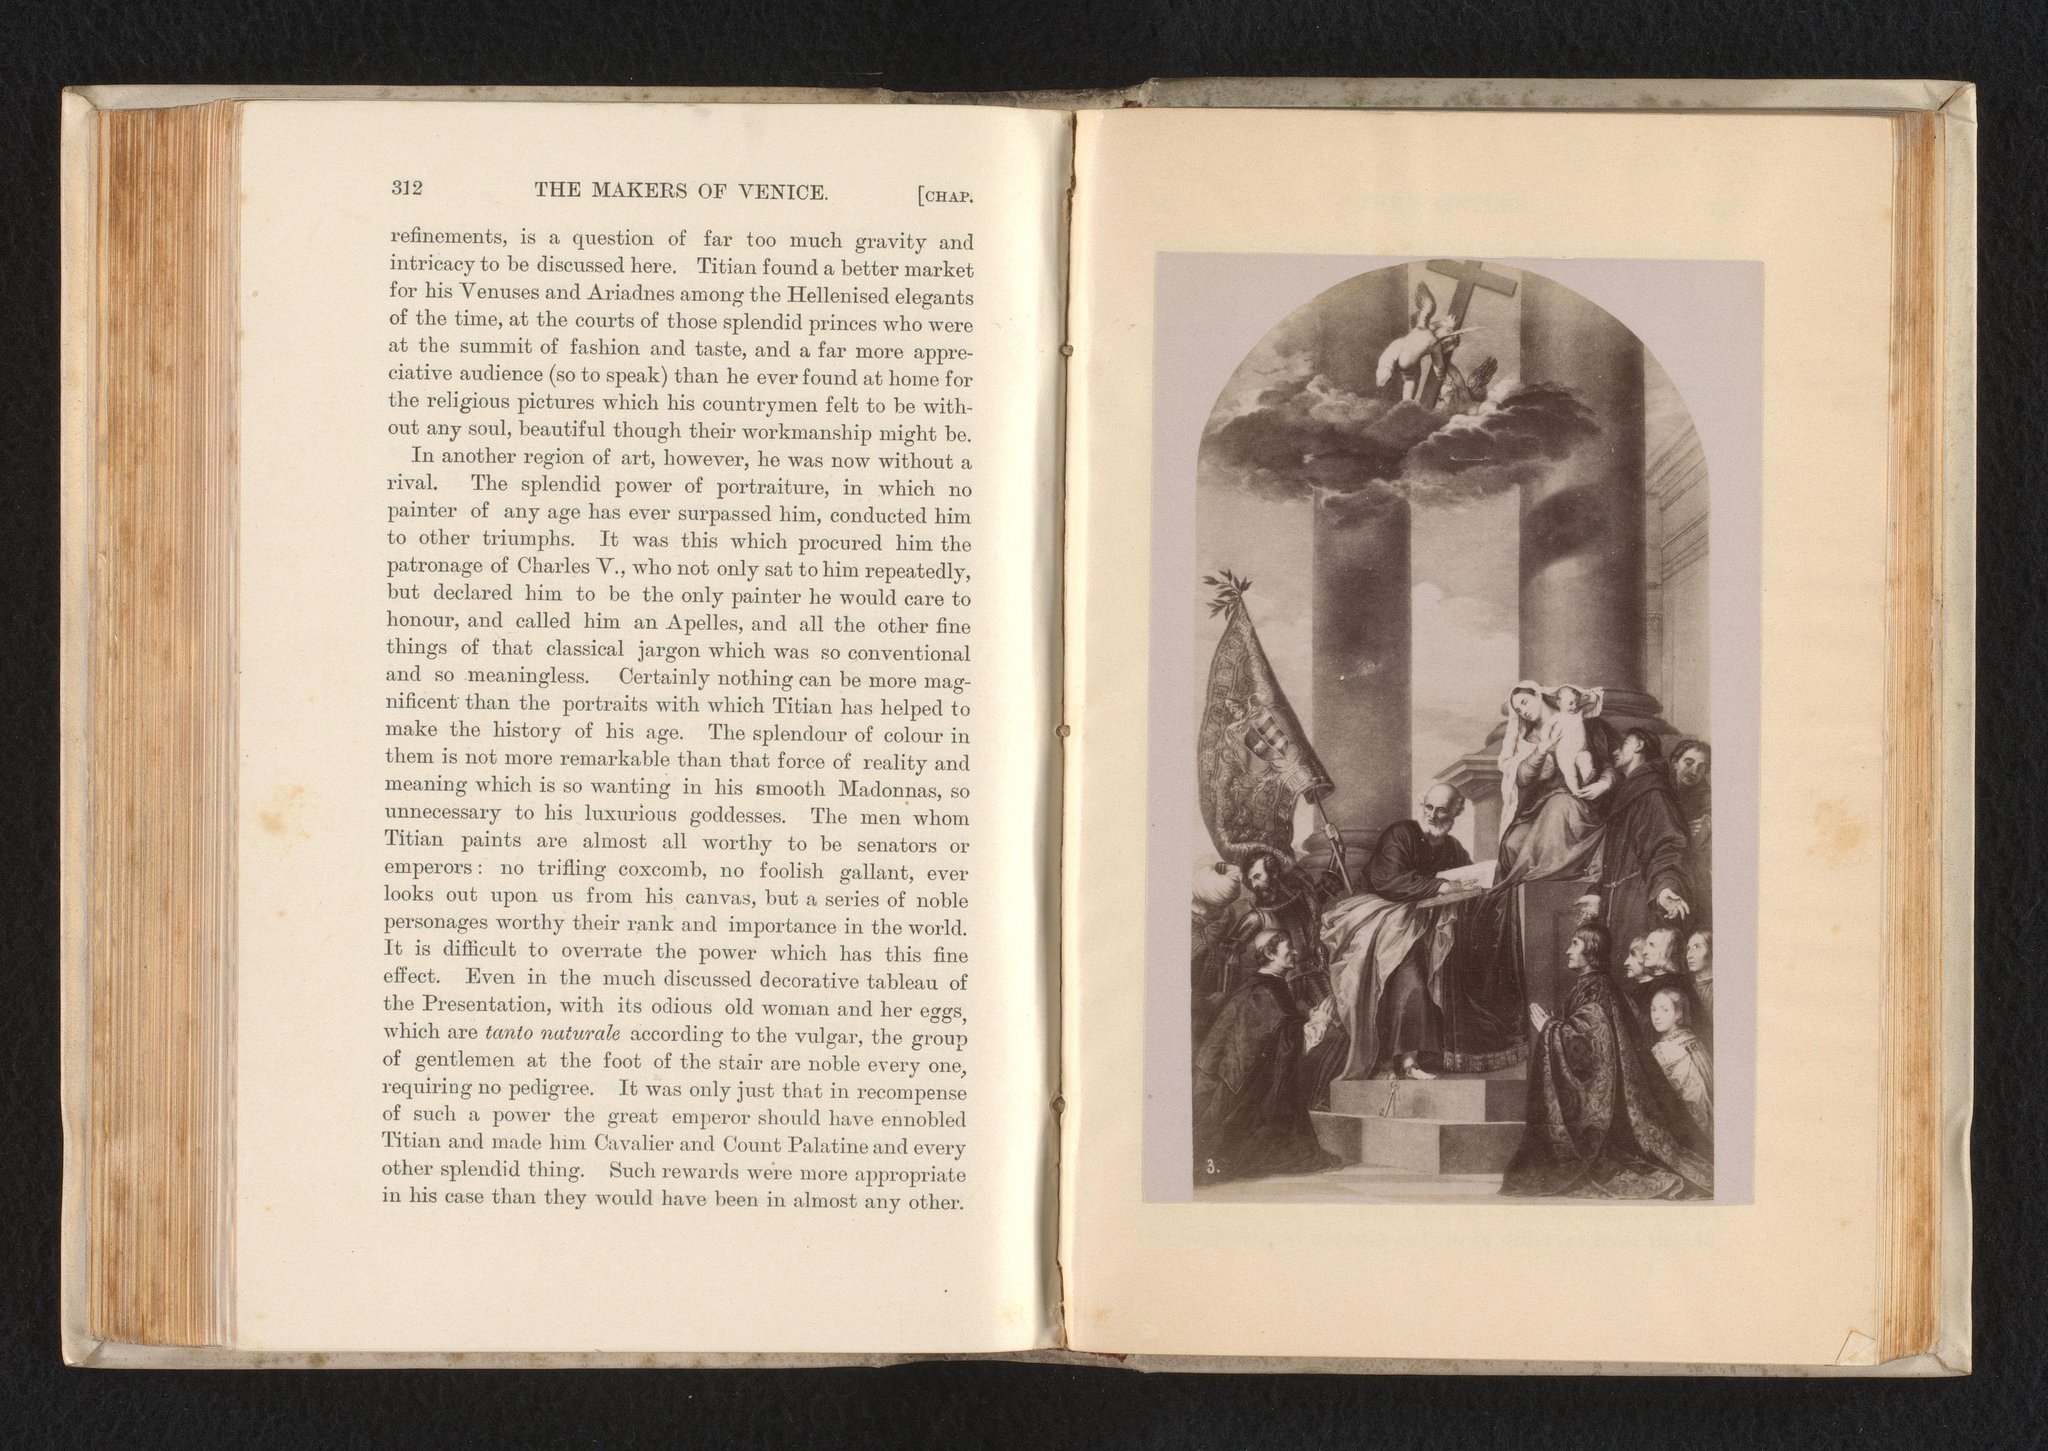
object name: reproduction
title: Fotoreproductie van het schilderij 'Pesaro Madonna' door Titiaan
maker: Anonymous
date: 1888-1893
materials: paper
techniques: albumen print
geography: venice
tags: madonna: i.e. mary with the christ-child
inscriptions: number: ‘3.’